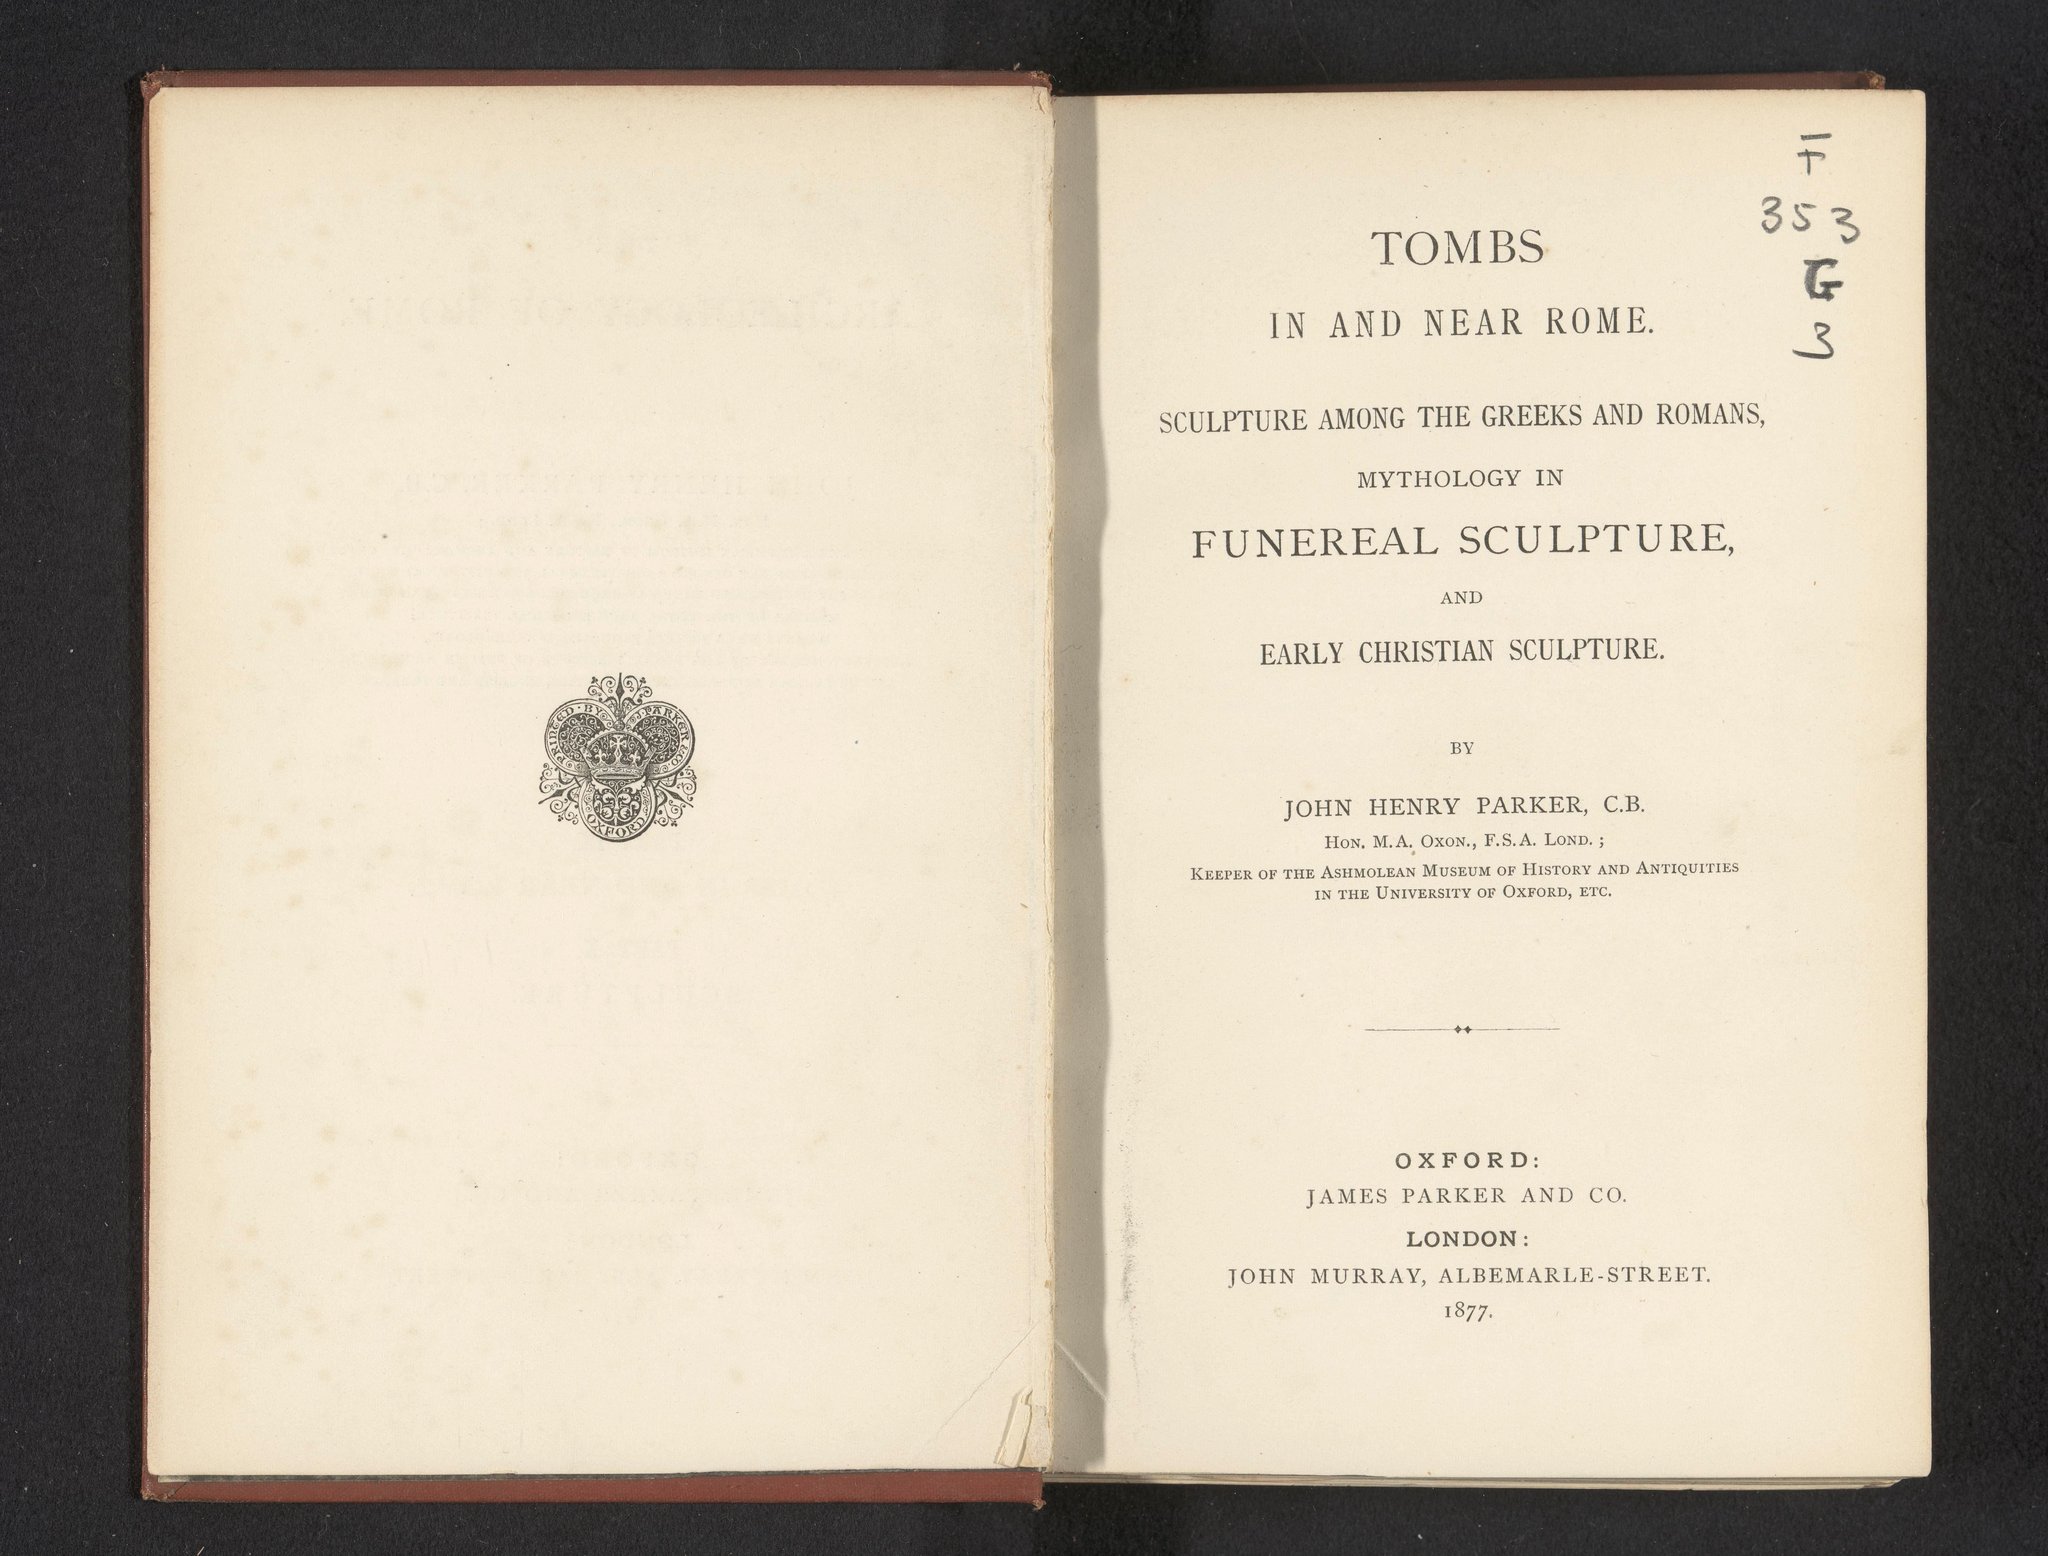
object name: book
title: Tombs in and near Rome sculpture among the Greeks and Romans, mythology in funereal sculpture, and early Christian sculpture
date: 1877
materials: linen, paper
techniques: photograph, photoaquatint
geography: oxford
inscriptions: name: ‘Heroum Filii Boys Library. Wellington College.’